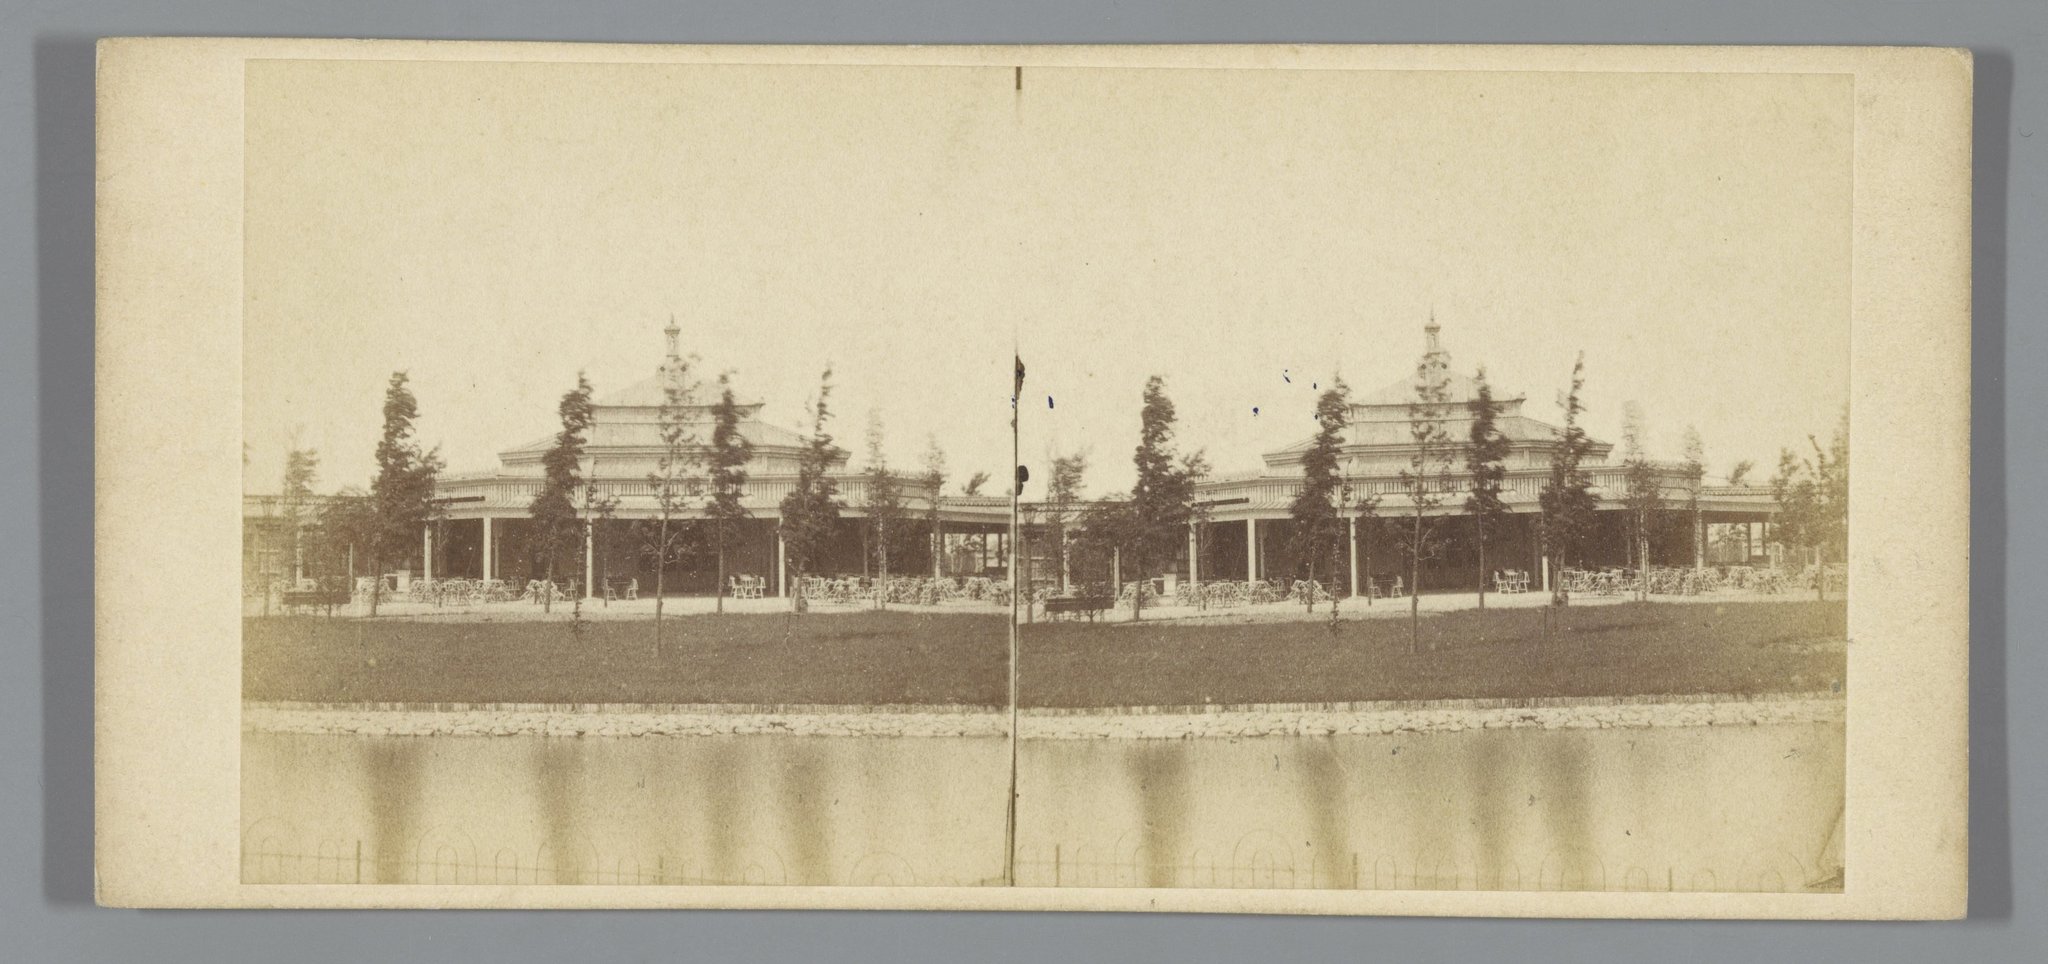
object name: stereograph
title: Vues de Hollande. Rotterdam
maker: pieter oosterhuis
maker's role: draughtsman, print maker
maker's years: 1816-1885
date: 1859-1865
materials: cardboard, paper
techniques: albumen print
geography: rotterdam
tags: zoo (as place of recreation)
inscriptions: number: ‘No. 227’